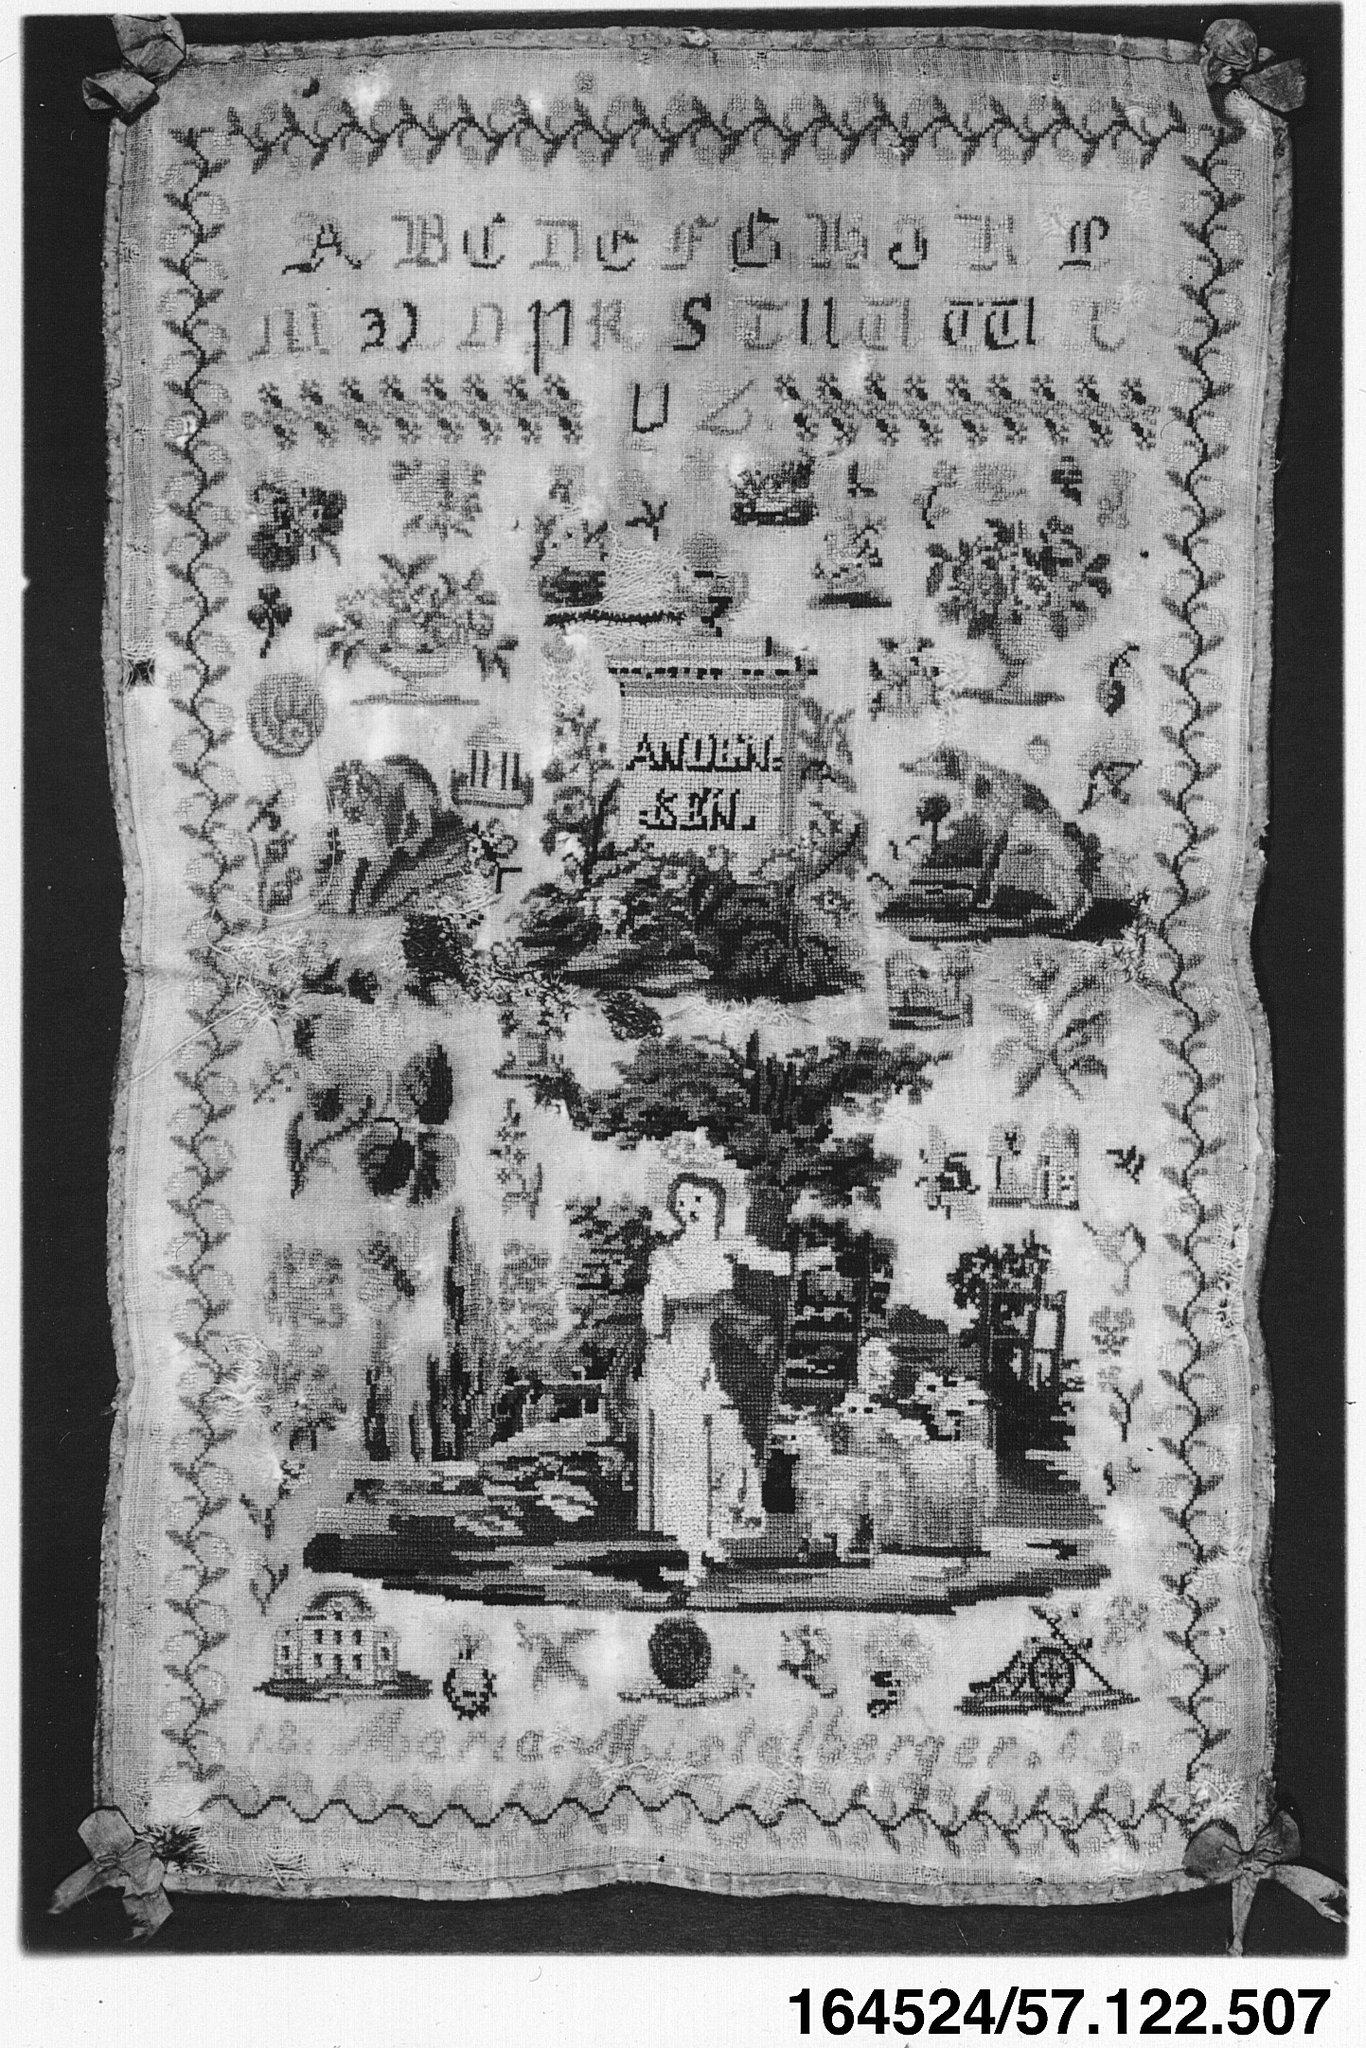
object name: sampler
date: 1889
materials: canvas, silk, wool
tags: animals,women